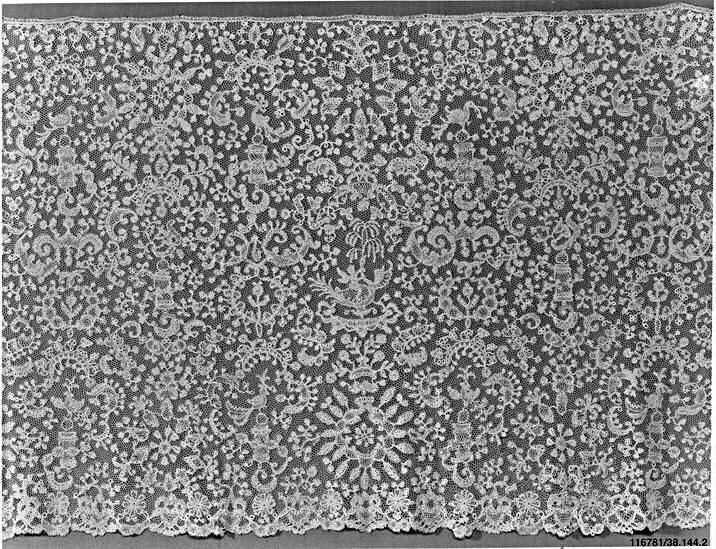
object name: flounce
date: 1701-1733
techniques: lace